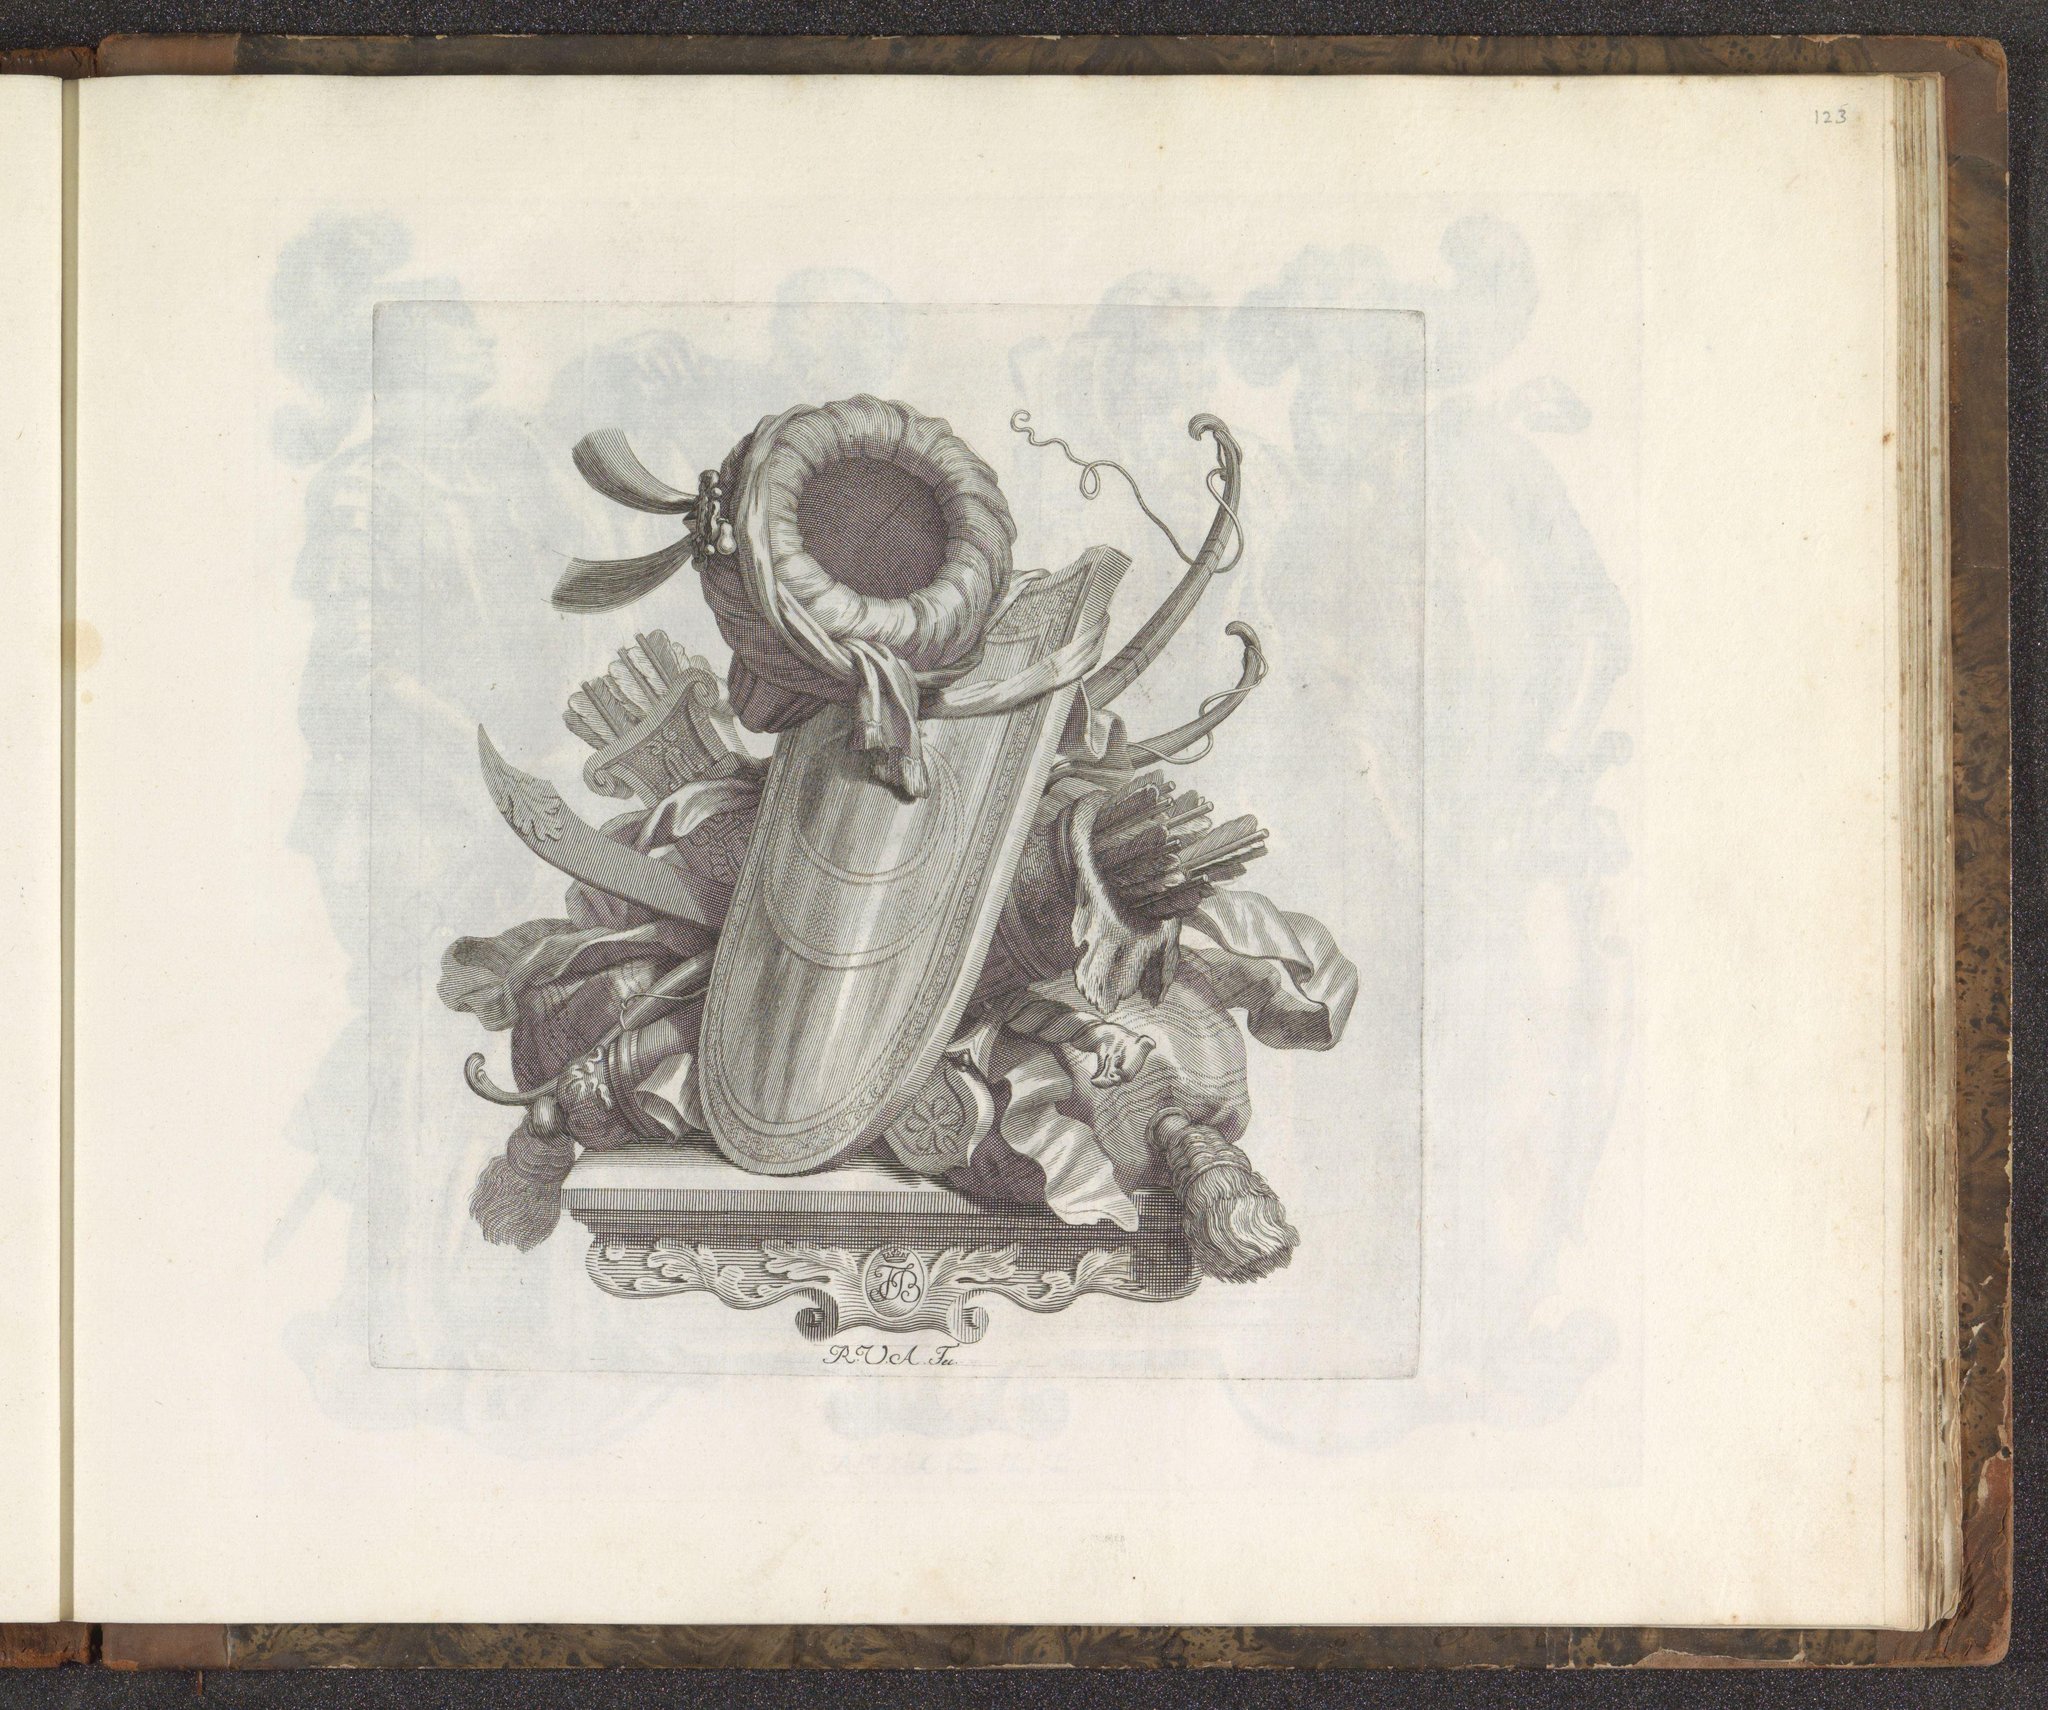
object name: album leaf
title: Trofee van Ottomaanse wapens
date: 1673-1743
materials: paper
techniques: engraving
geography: rome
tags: trophy, i.e.: decorative arrangement of symbolic or typical objects ~ ornament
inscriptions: collector's mark: Lugt 2228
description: Een console met een trofee bestaande uit buitgemaakte Ottomaanse wapens en attributen, zoals een schild met halve maan, een tulband, pijlkokers en kromzwaard. De prent maakt deel uit van een album.